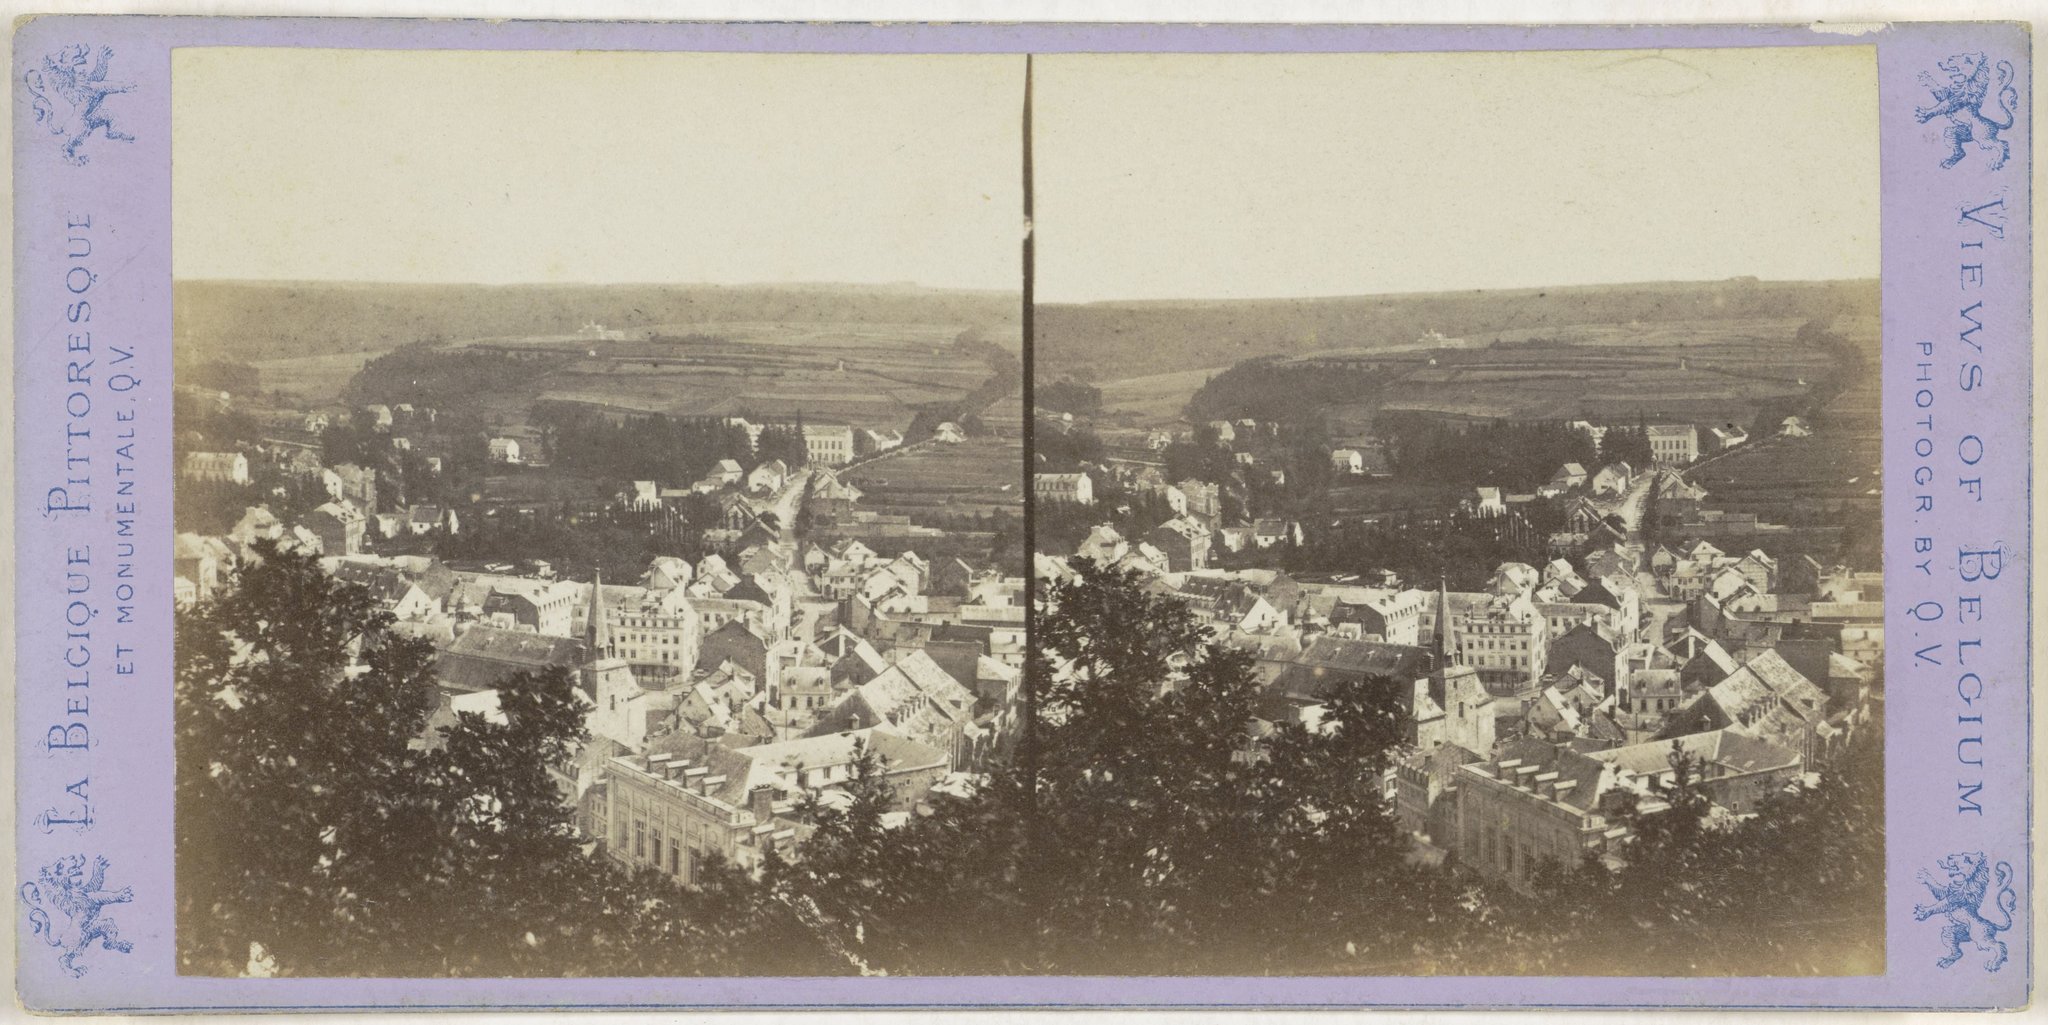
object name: stereograph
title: Spa, vue générale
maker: jules hippolyte quéval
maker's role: publisher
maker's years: 1824-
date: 1866-1870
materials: cardboard, paper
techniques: albumen print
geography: spa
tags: village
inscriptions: number: ‘No 1776’